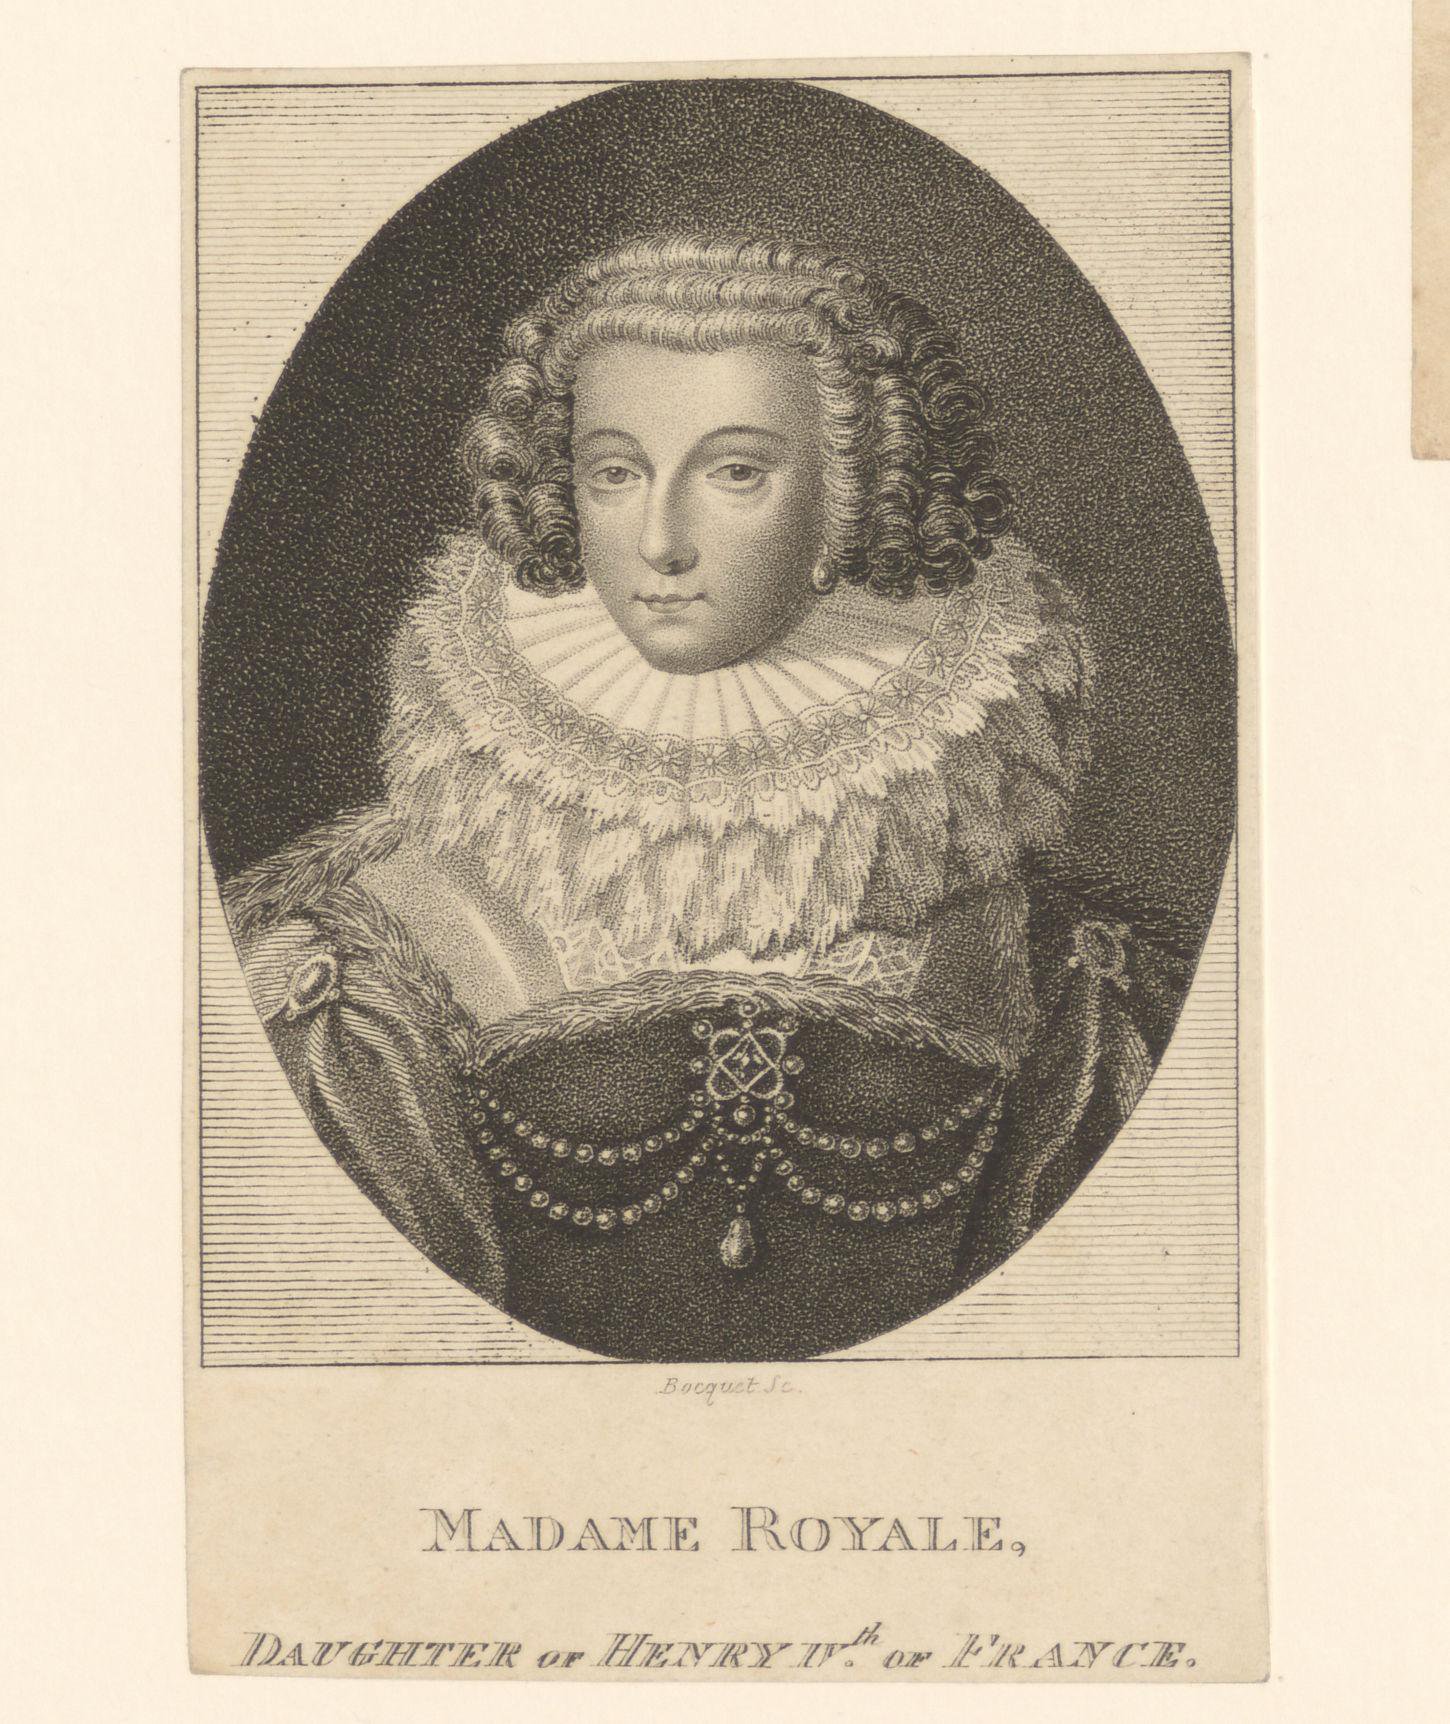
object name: print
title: Portret van Elisabeth van Frankrijk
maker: e. bocquet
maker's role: print maker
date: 1800-1830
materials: paper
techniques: engraving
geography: england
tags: elisabeth of france (queen of spain and portugal), historical persons, queen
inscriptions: collector's mark: Lugt 2228